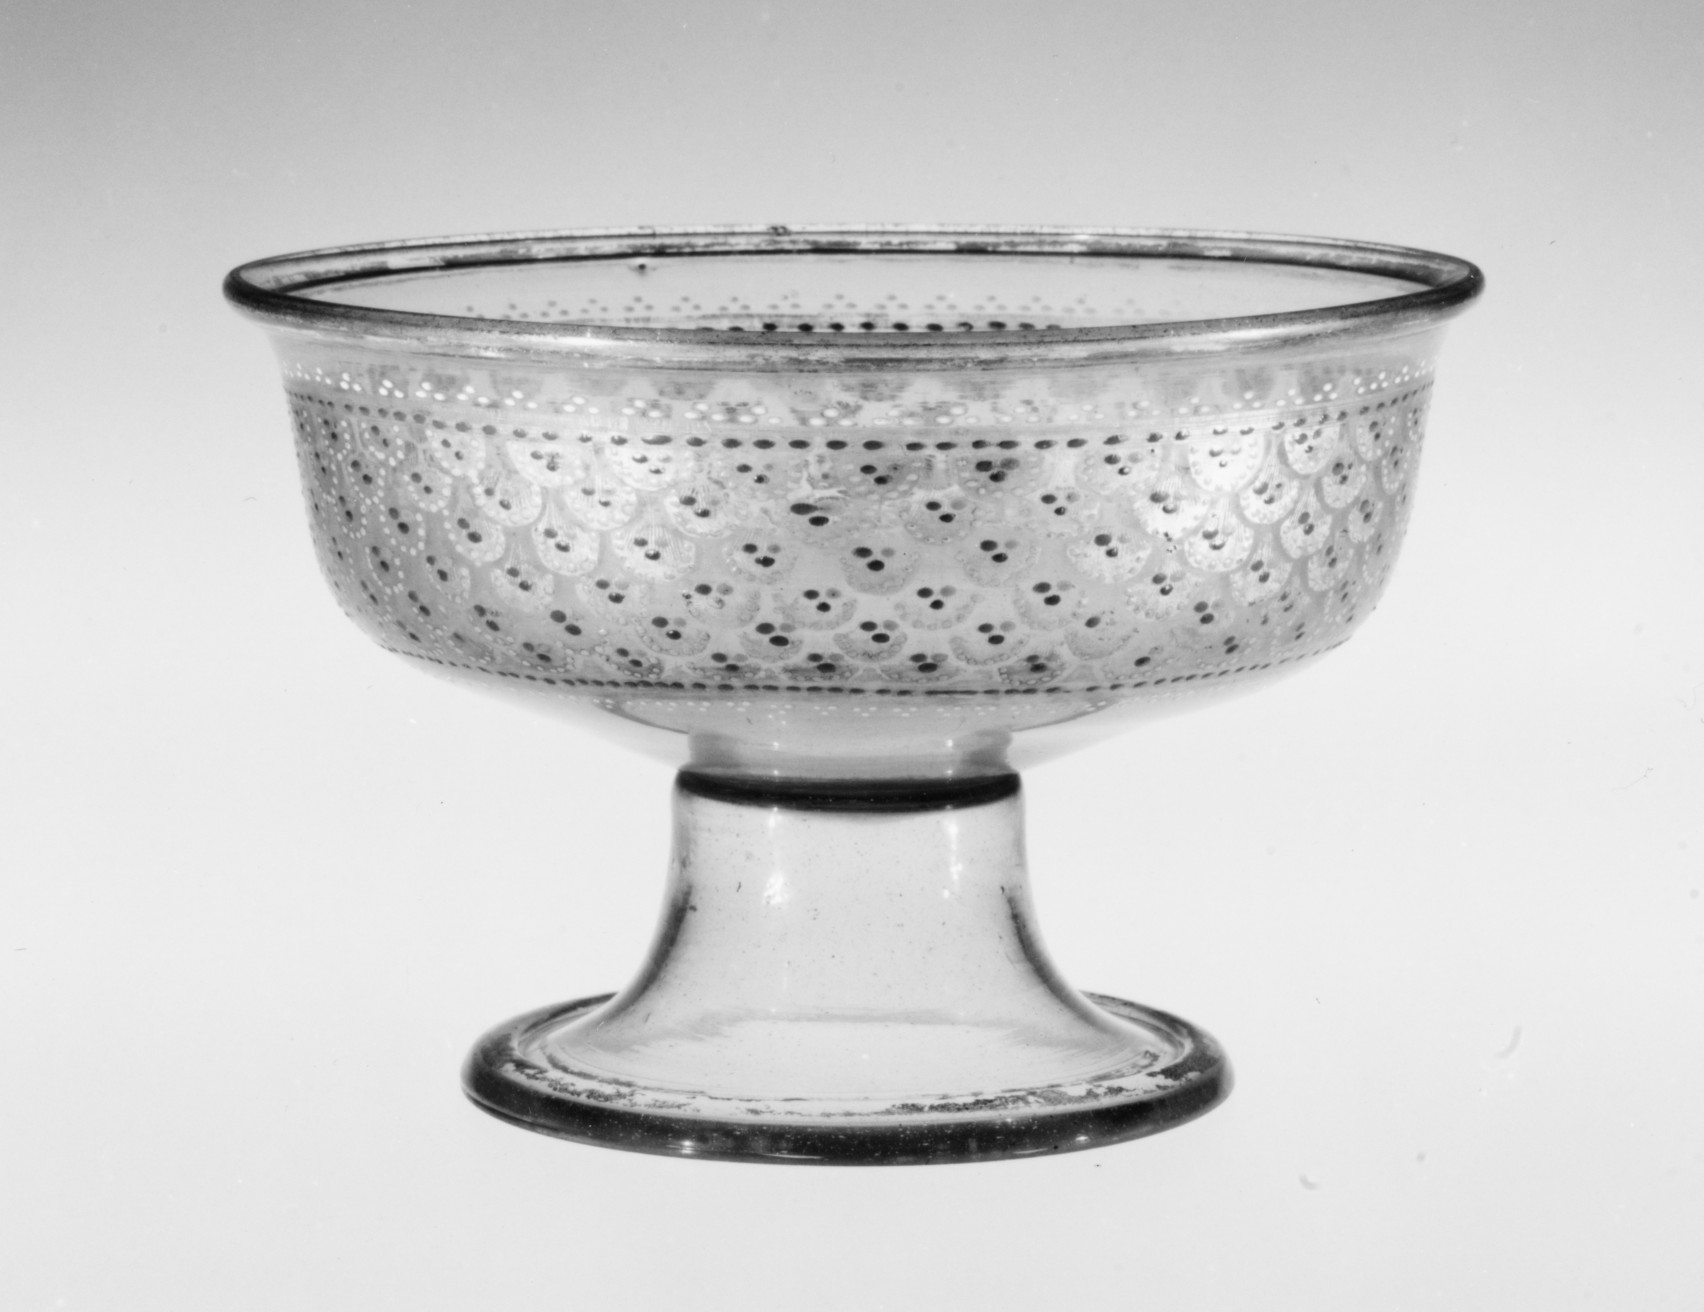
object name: bowl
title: Footed bowl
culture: italian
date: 1500-1525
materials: gilt, glass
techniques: glassblowing, enamel